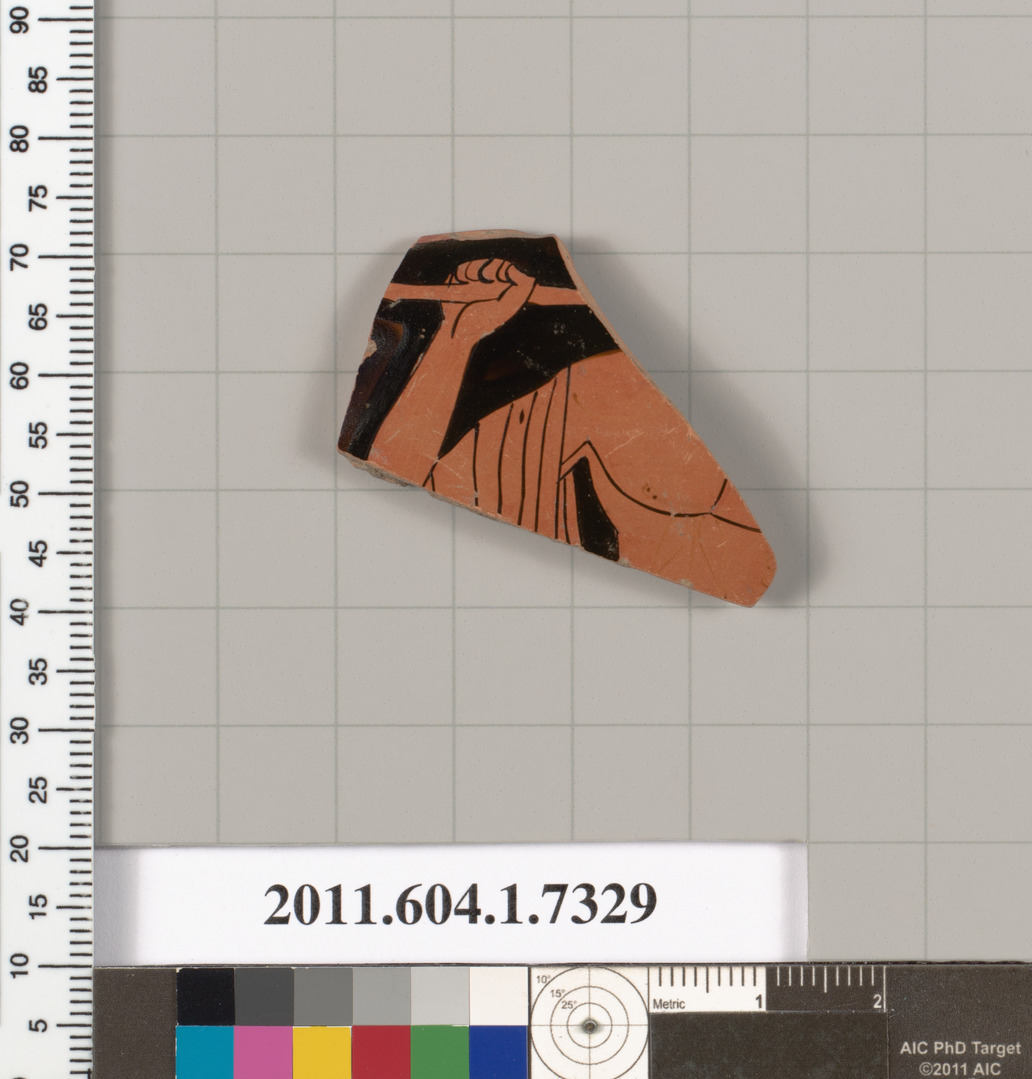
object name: kylix fragment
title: Terracotta rim fragment of a kylix (drinking cup)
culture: greek, attic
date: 500-480 BCE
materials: terracotta